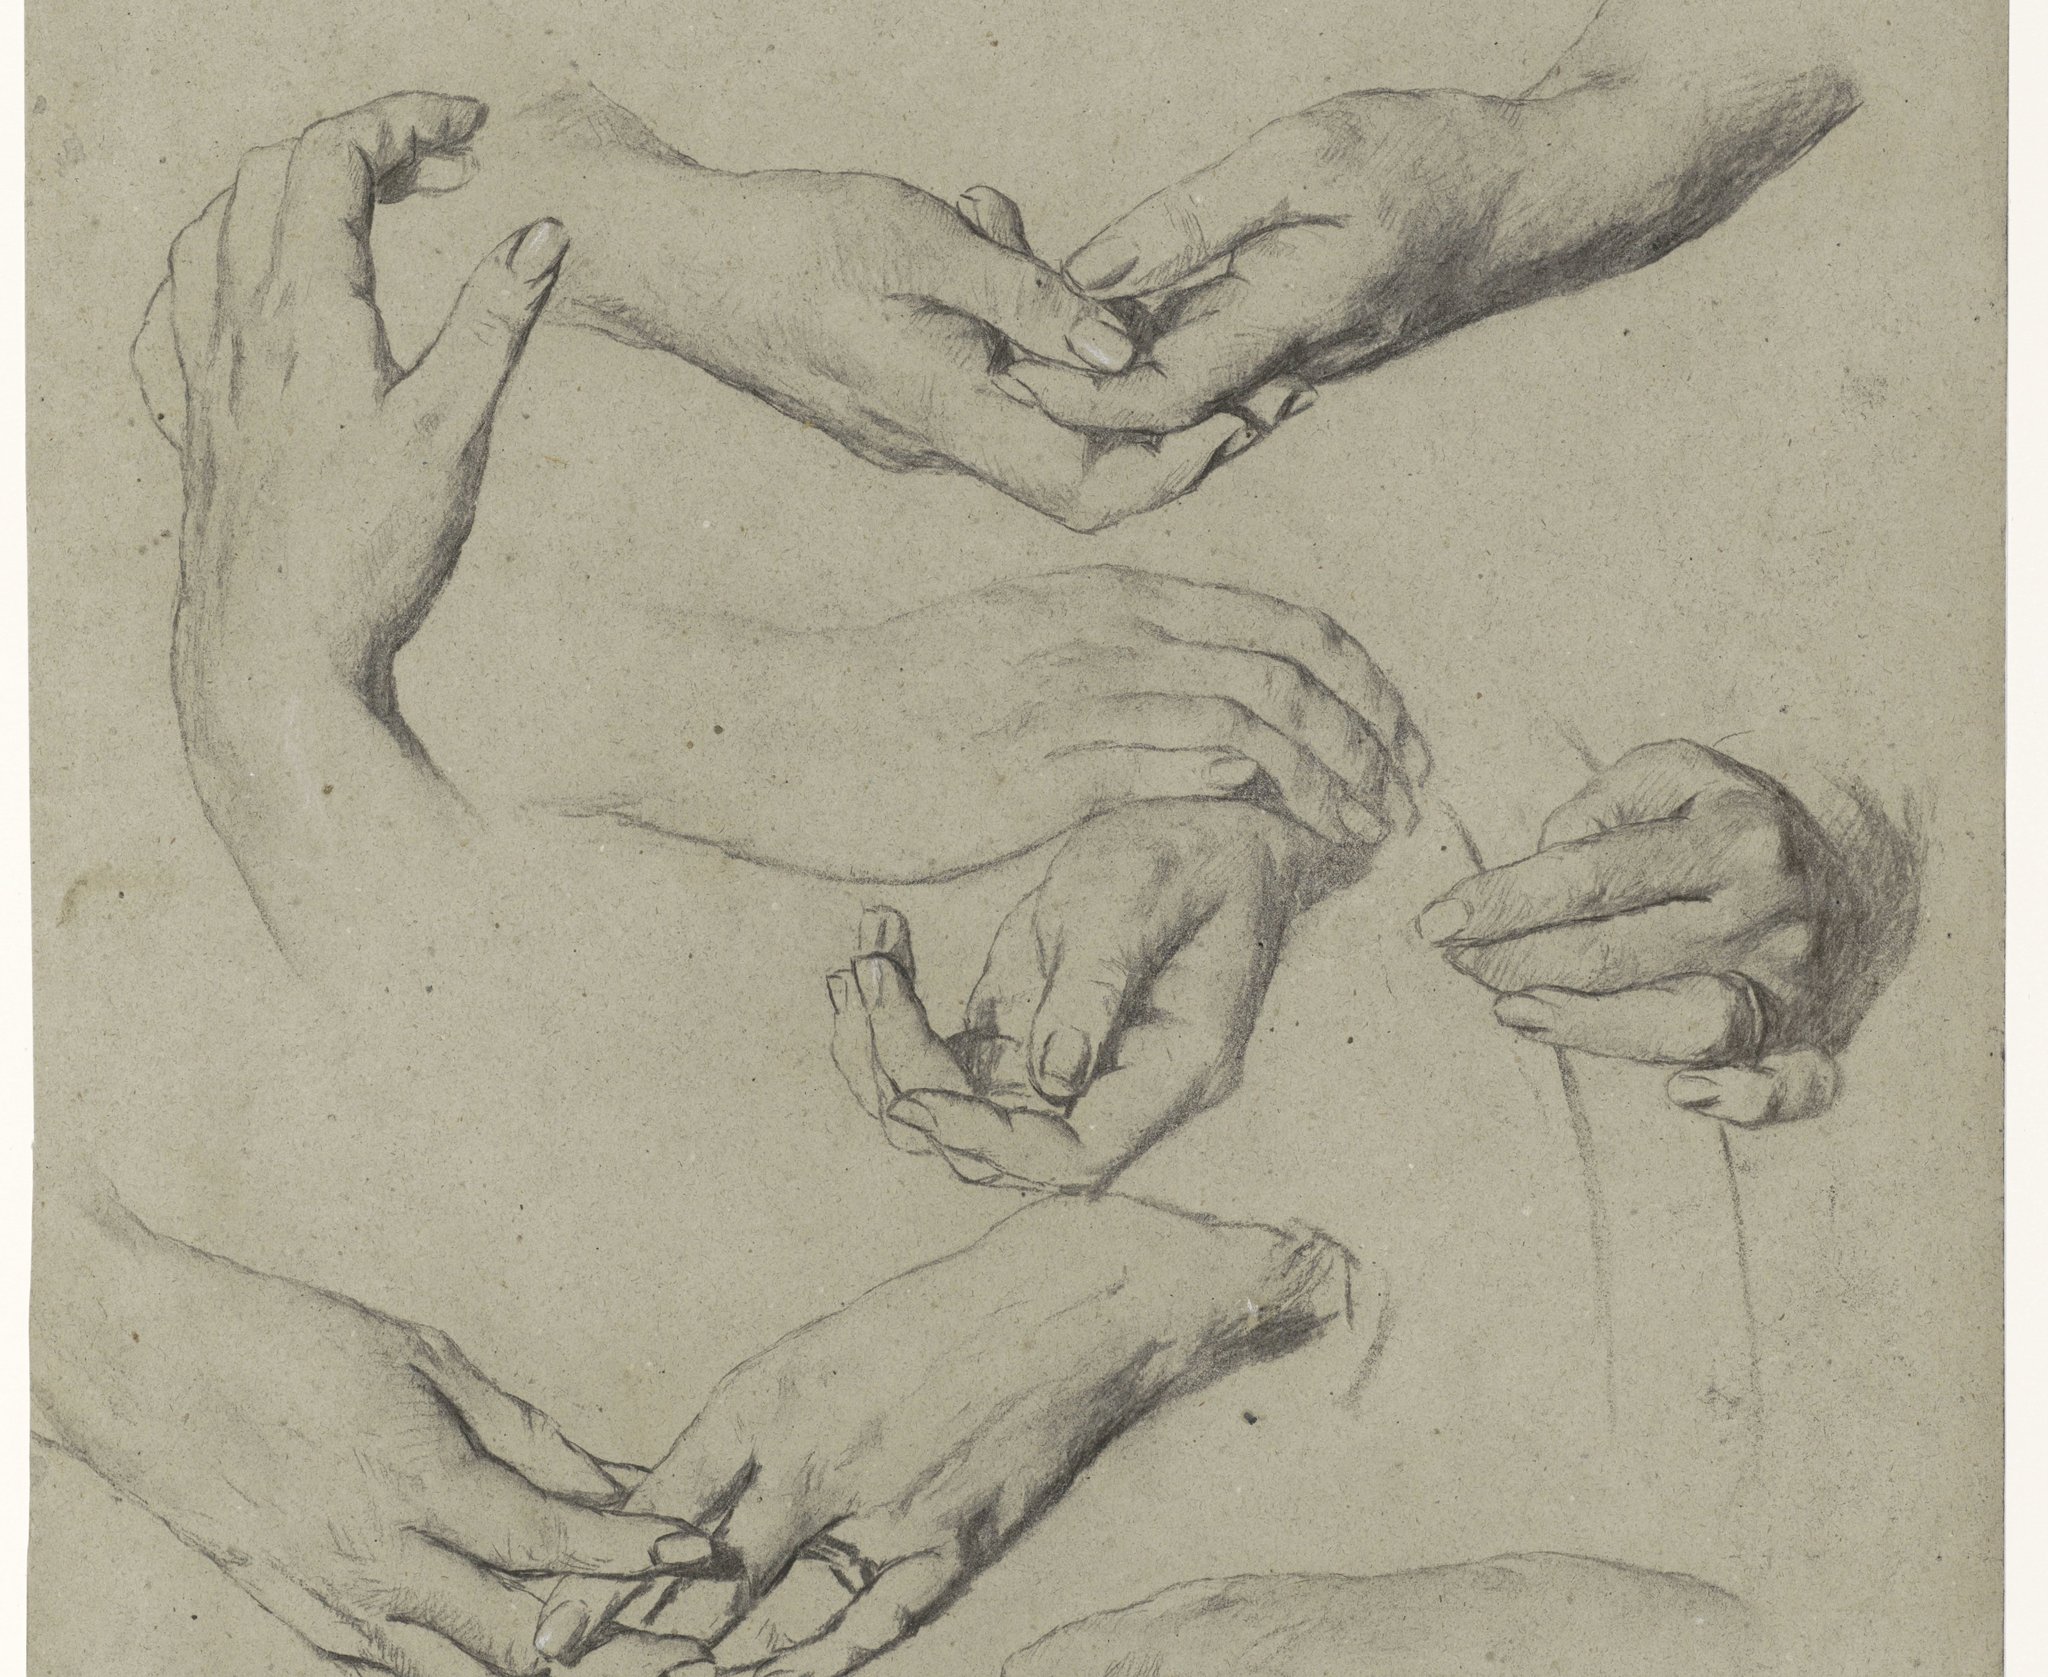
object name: drawing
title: Studies van handen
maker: thérèse schwartze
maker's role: draughtsman, painter, print maker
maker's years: 1851-1918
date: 1861-1918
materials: chalk, paper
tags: postures and gestures of hand and fingers, postures and gestures of arms and hands in relation to each other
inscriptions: annotation: ‘Studie's van Therese Schwartze’